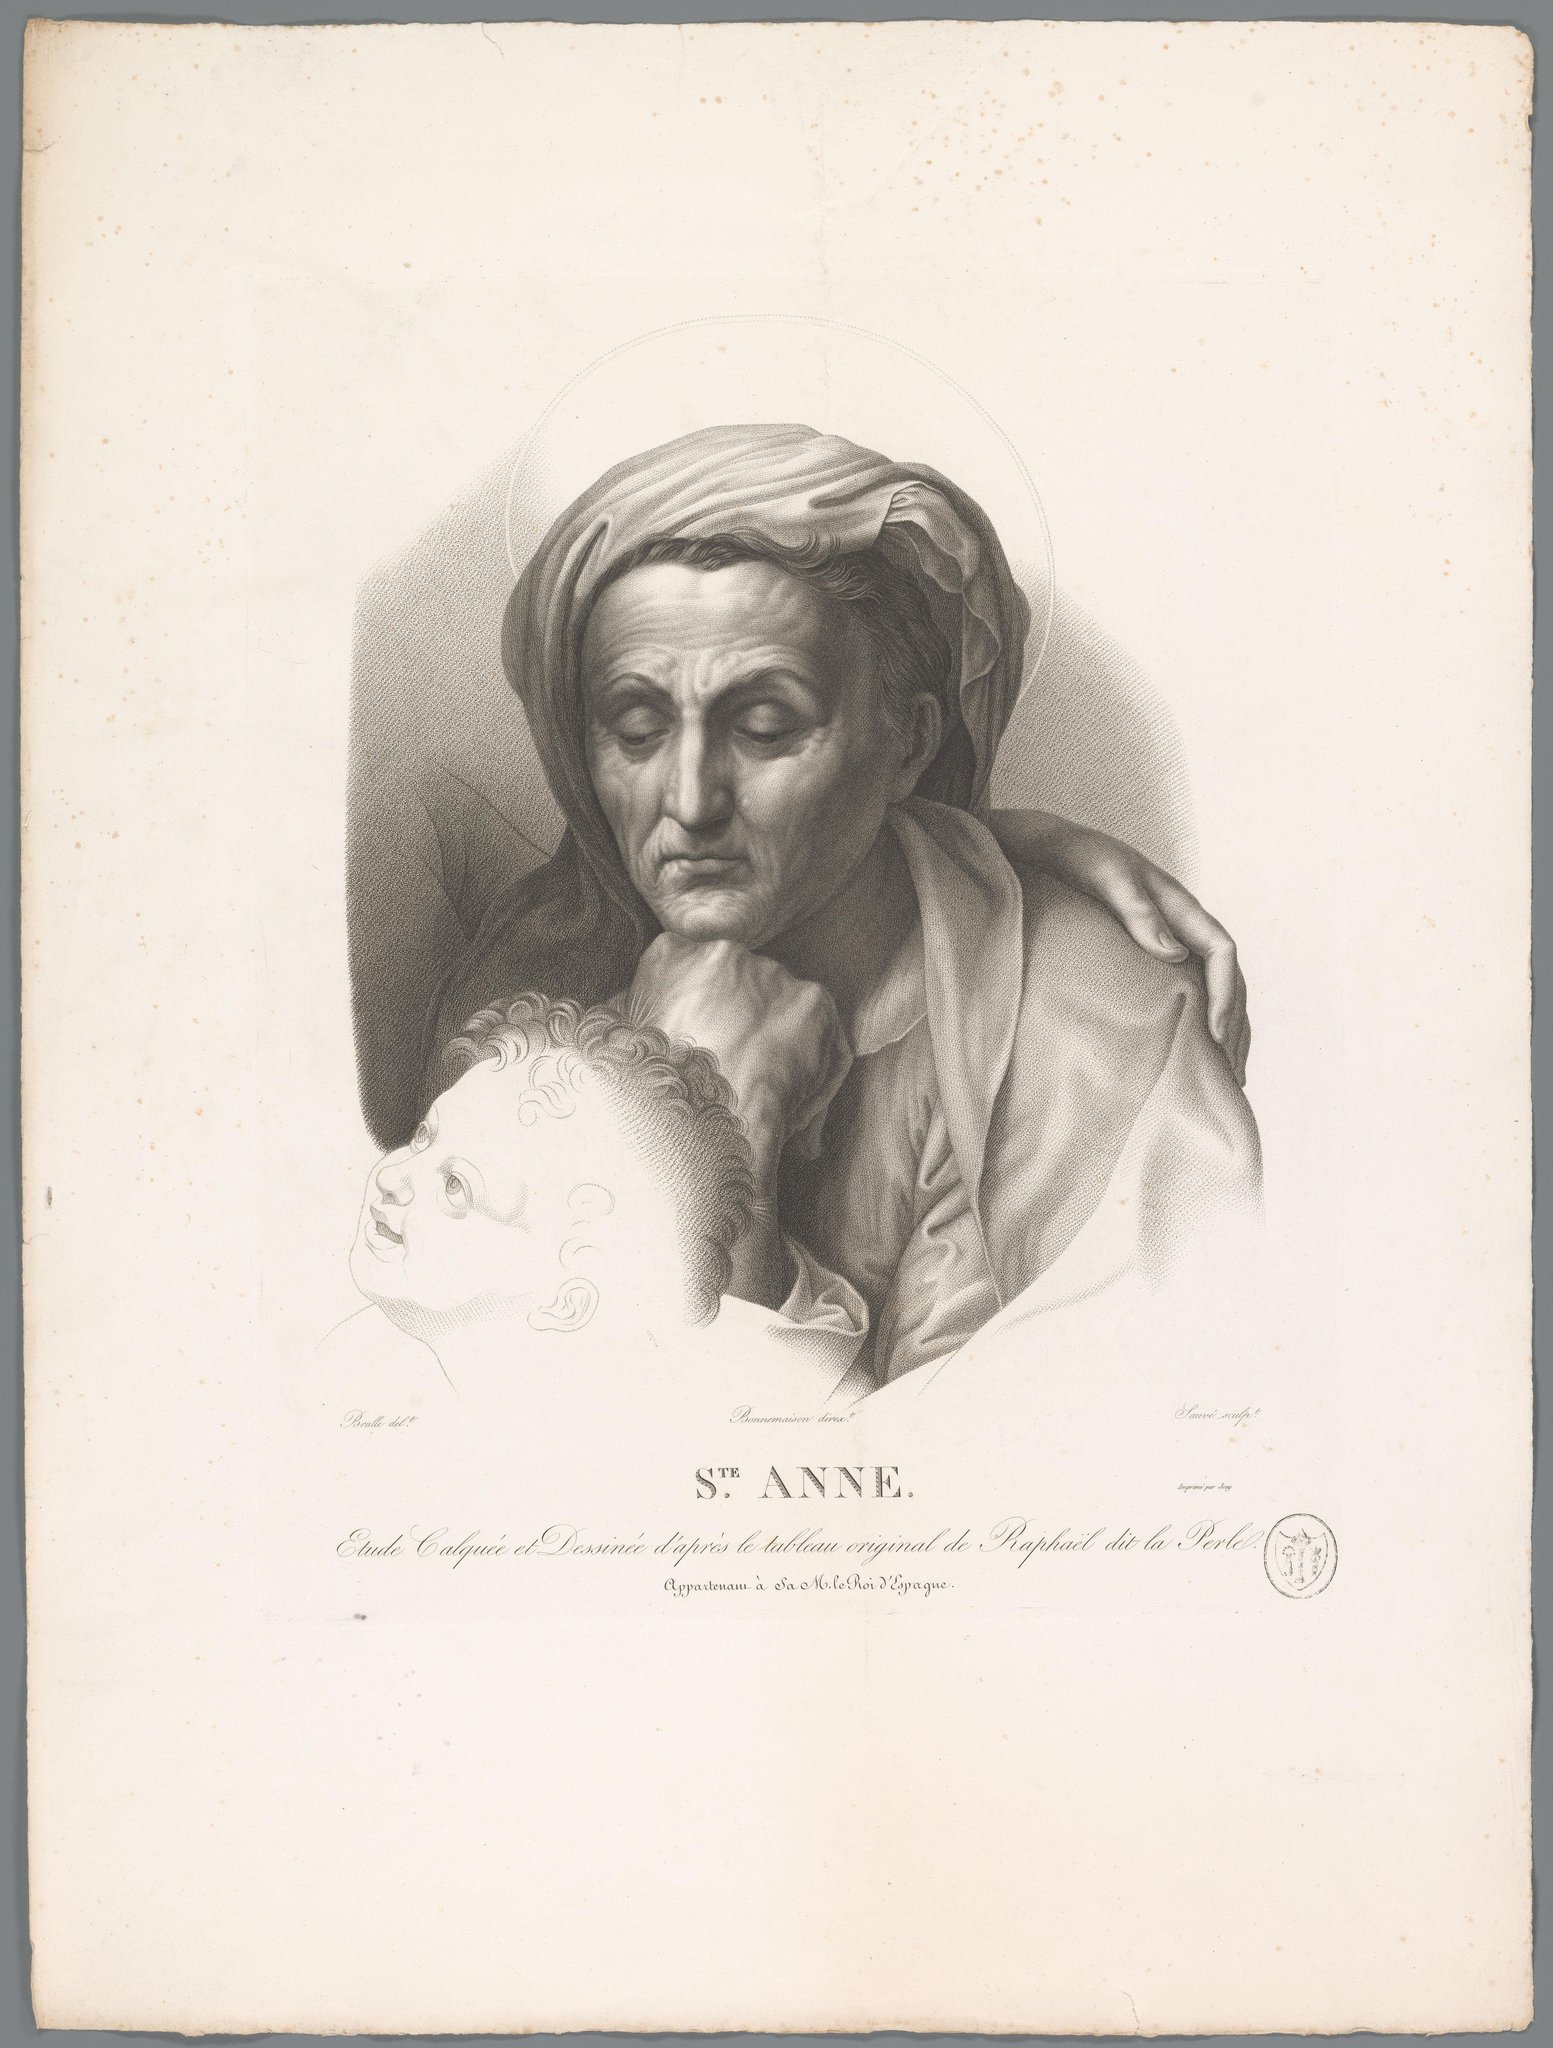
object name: print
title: Suite d'Études calquées et dessinées d'après Cinq Tableaux de Raphaël (...)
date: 1818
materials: paper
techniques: printmaking, engraving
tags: later life of anna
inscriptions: collector's mark: Lugt 4583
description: Maakt deel uit van een omslag met 8 prenten en 5 tekstbladen naar details van schilderijen door Rafaël. De serie kwam tot stand onder toezicht van Féréol Bonnemaison en werd voorzien van tekst door Toussaint-Bernard Émeric-David. Het geheel werd uitgegeven door Féréol Bonnemaison en Mesdemoiselles Érard te Parijs en gedrukt door Pierre I Didot in 1818. Dit betreft een detail van Heilige Familie met Anna en Johannes de Doper dat zich in de collectie van het Museo del Prado in Madrid, inv.nr. P000301, ook wel bekend als de 'Madonna della Perla'.